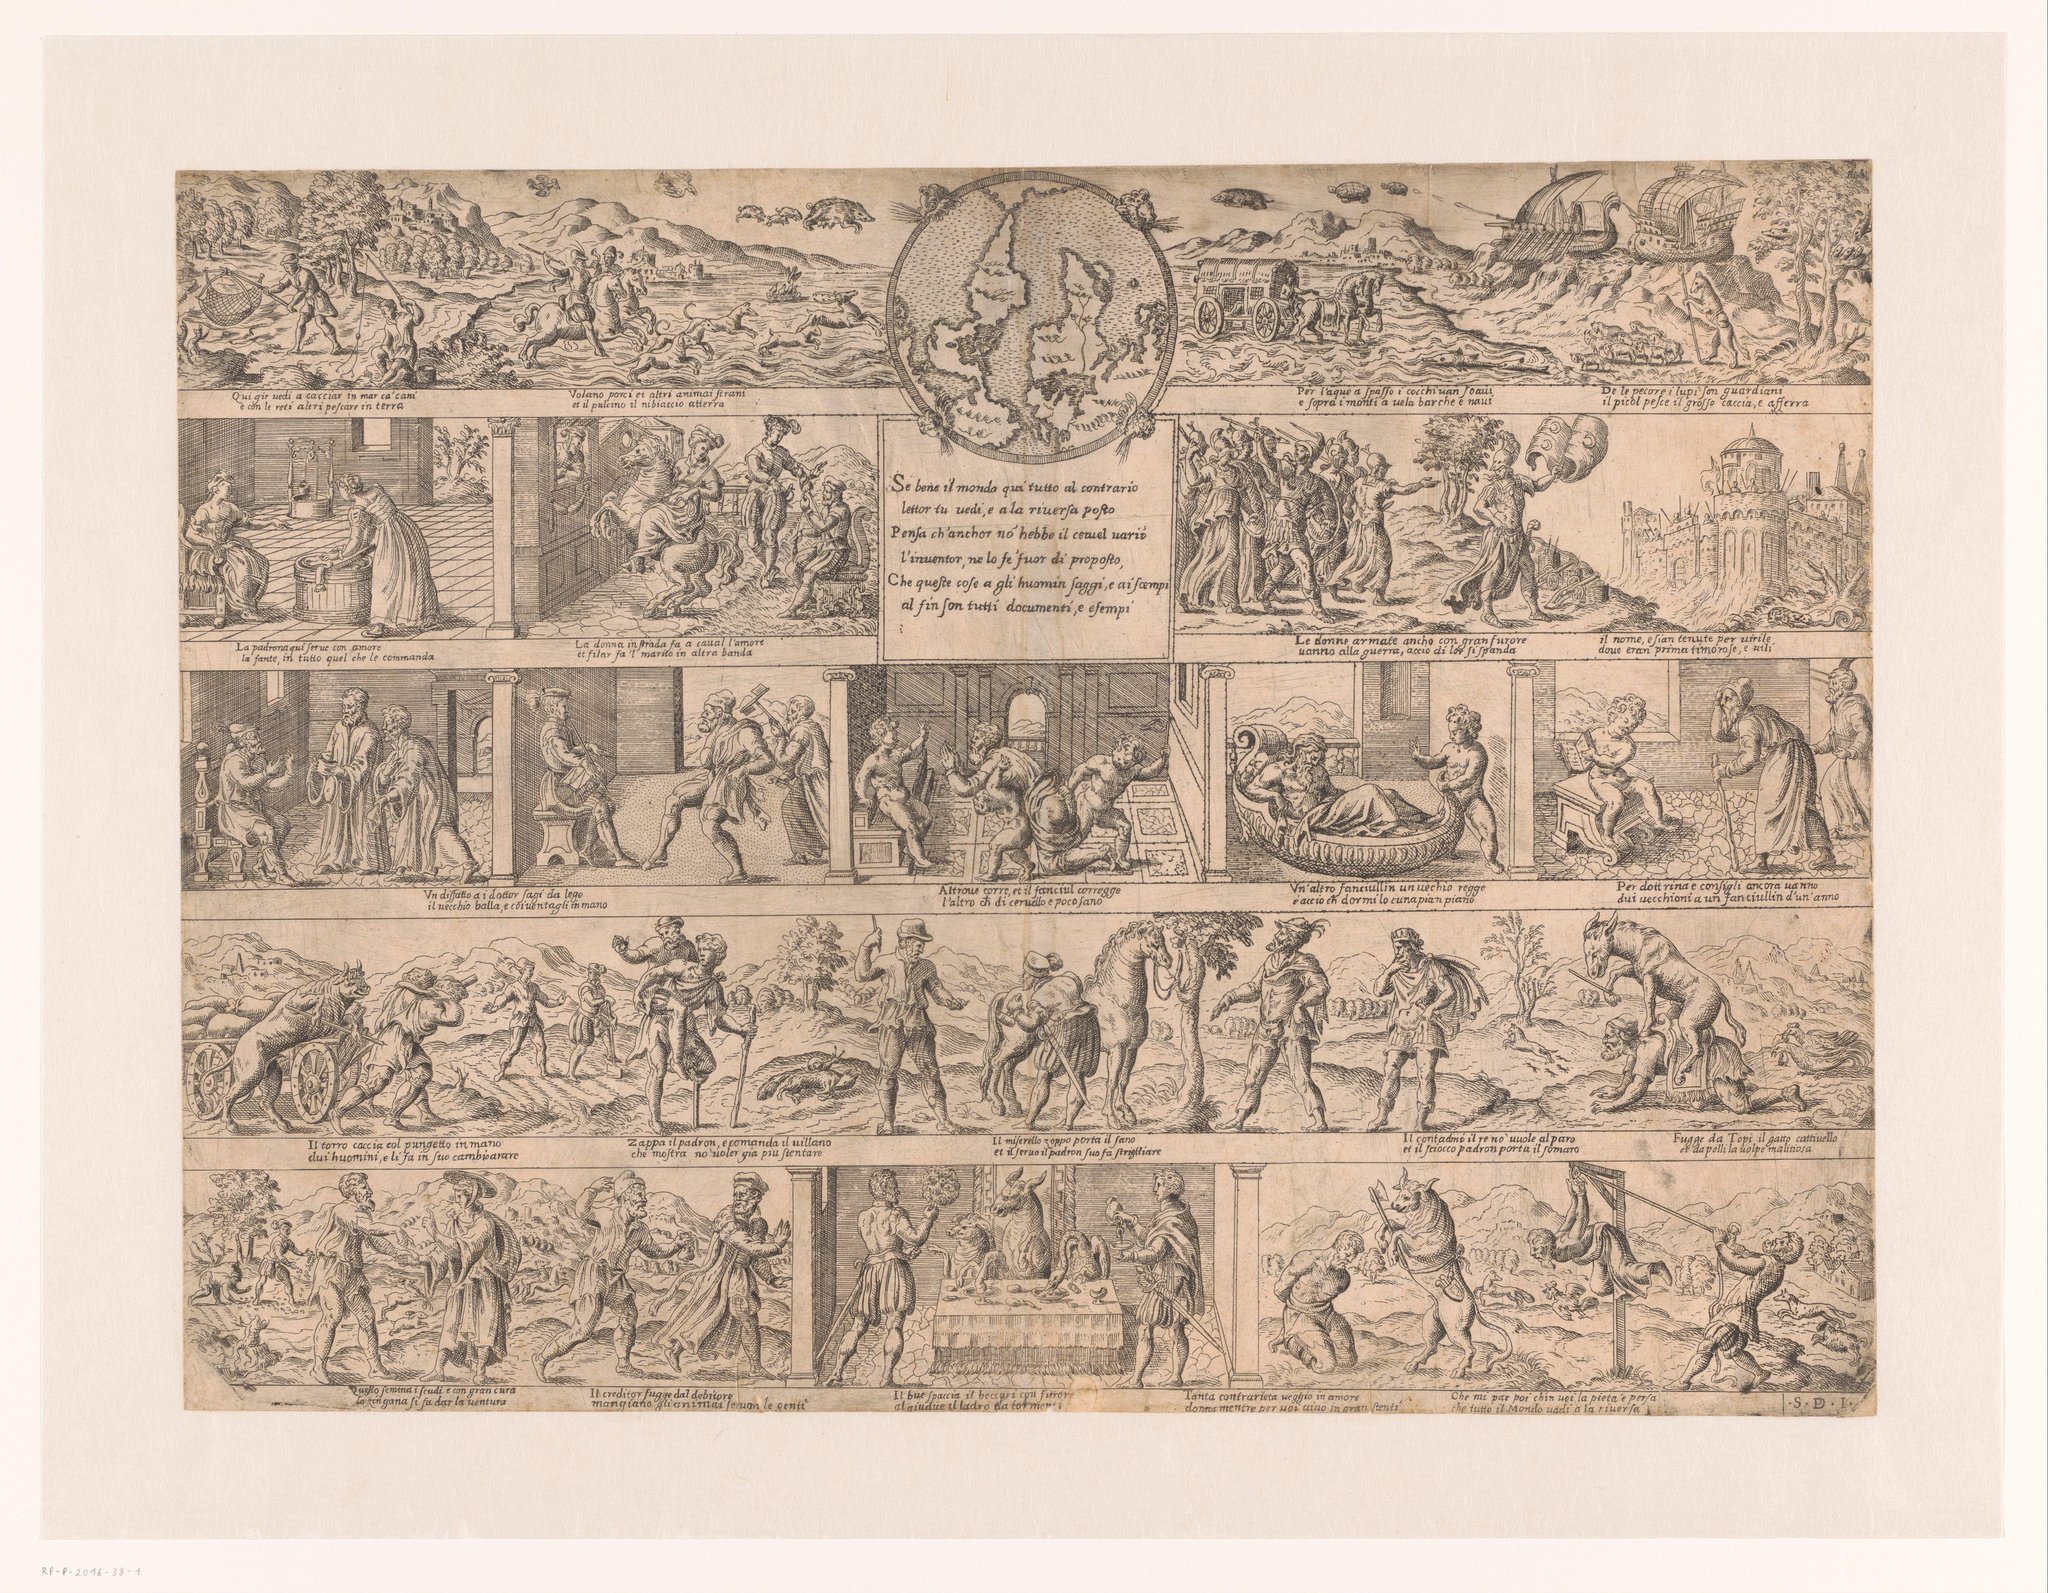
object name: print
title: Verkeerde wereld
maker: etienne dupérac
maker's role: draughtsman, painter, print maker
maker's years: 1525-1604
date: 1560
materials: paper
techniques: etching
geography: venice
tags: 'mundus inversus', the reversed world, the topsy-turvy world, 'le monde bestourné'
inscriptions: collector's mark: Lugt 2228, collector's mark: Lugt 2760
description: Blad waarop in vijf stroken allerlei voorstellingen te zien zijn van het leven in de verkeerde of omgekeerde wereld. Hierin ruilen dieren en mensen van plaats, bezigheden van het land naar de zee en omgekeerd, de rollen van ouders en kinderen en van meesters en knechten worden omgekeerd. Alles met onderschriften in het Italiaans.